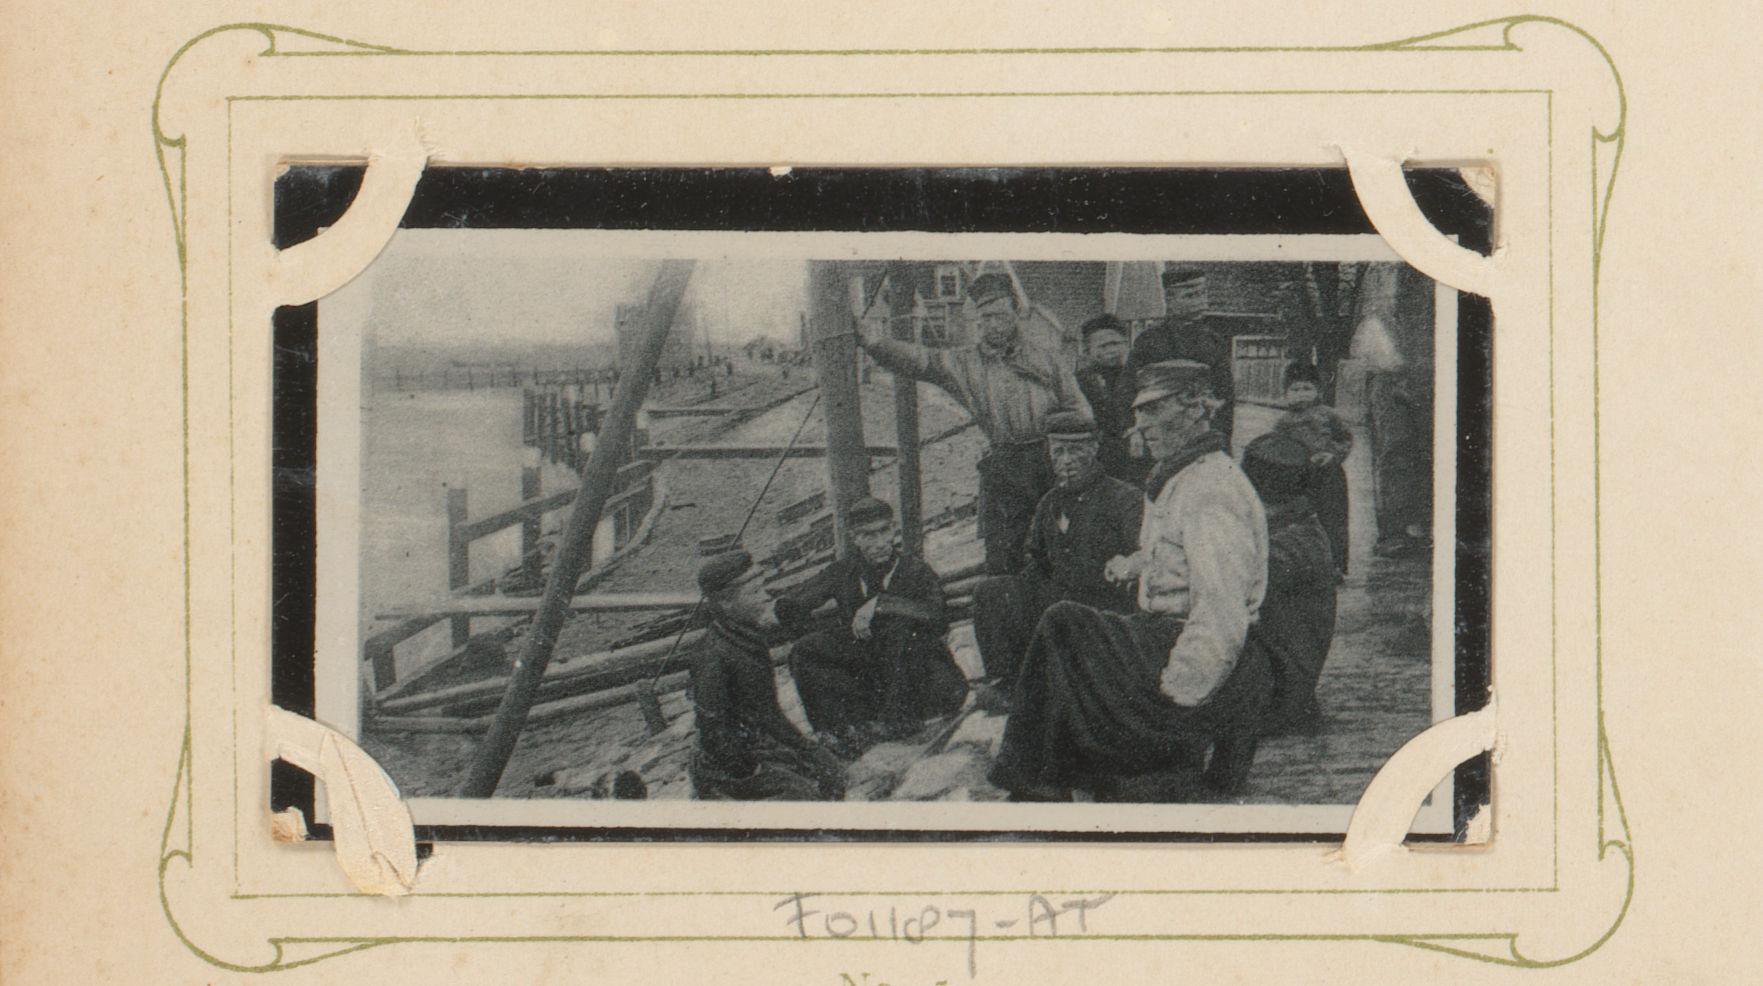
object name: album leaf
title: Groep mannen en jongens op de kade van een waterweg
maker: Anonymous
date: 1905-1906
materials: paper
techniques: photograph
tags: river bank, adult man (+ six persons), boy (child between toddler and youth) (+ three persons)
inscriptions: inscription: ‘No. 5./ Op den uitkijk.’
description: Deze prent maakt deel uit van een album.